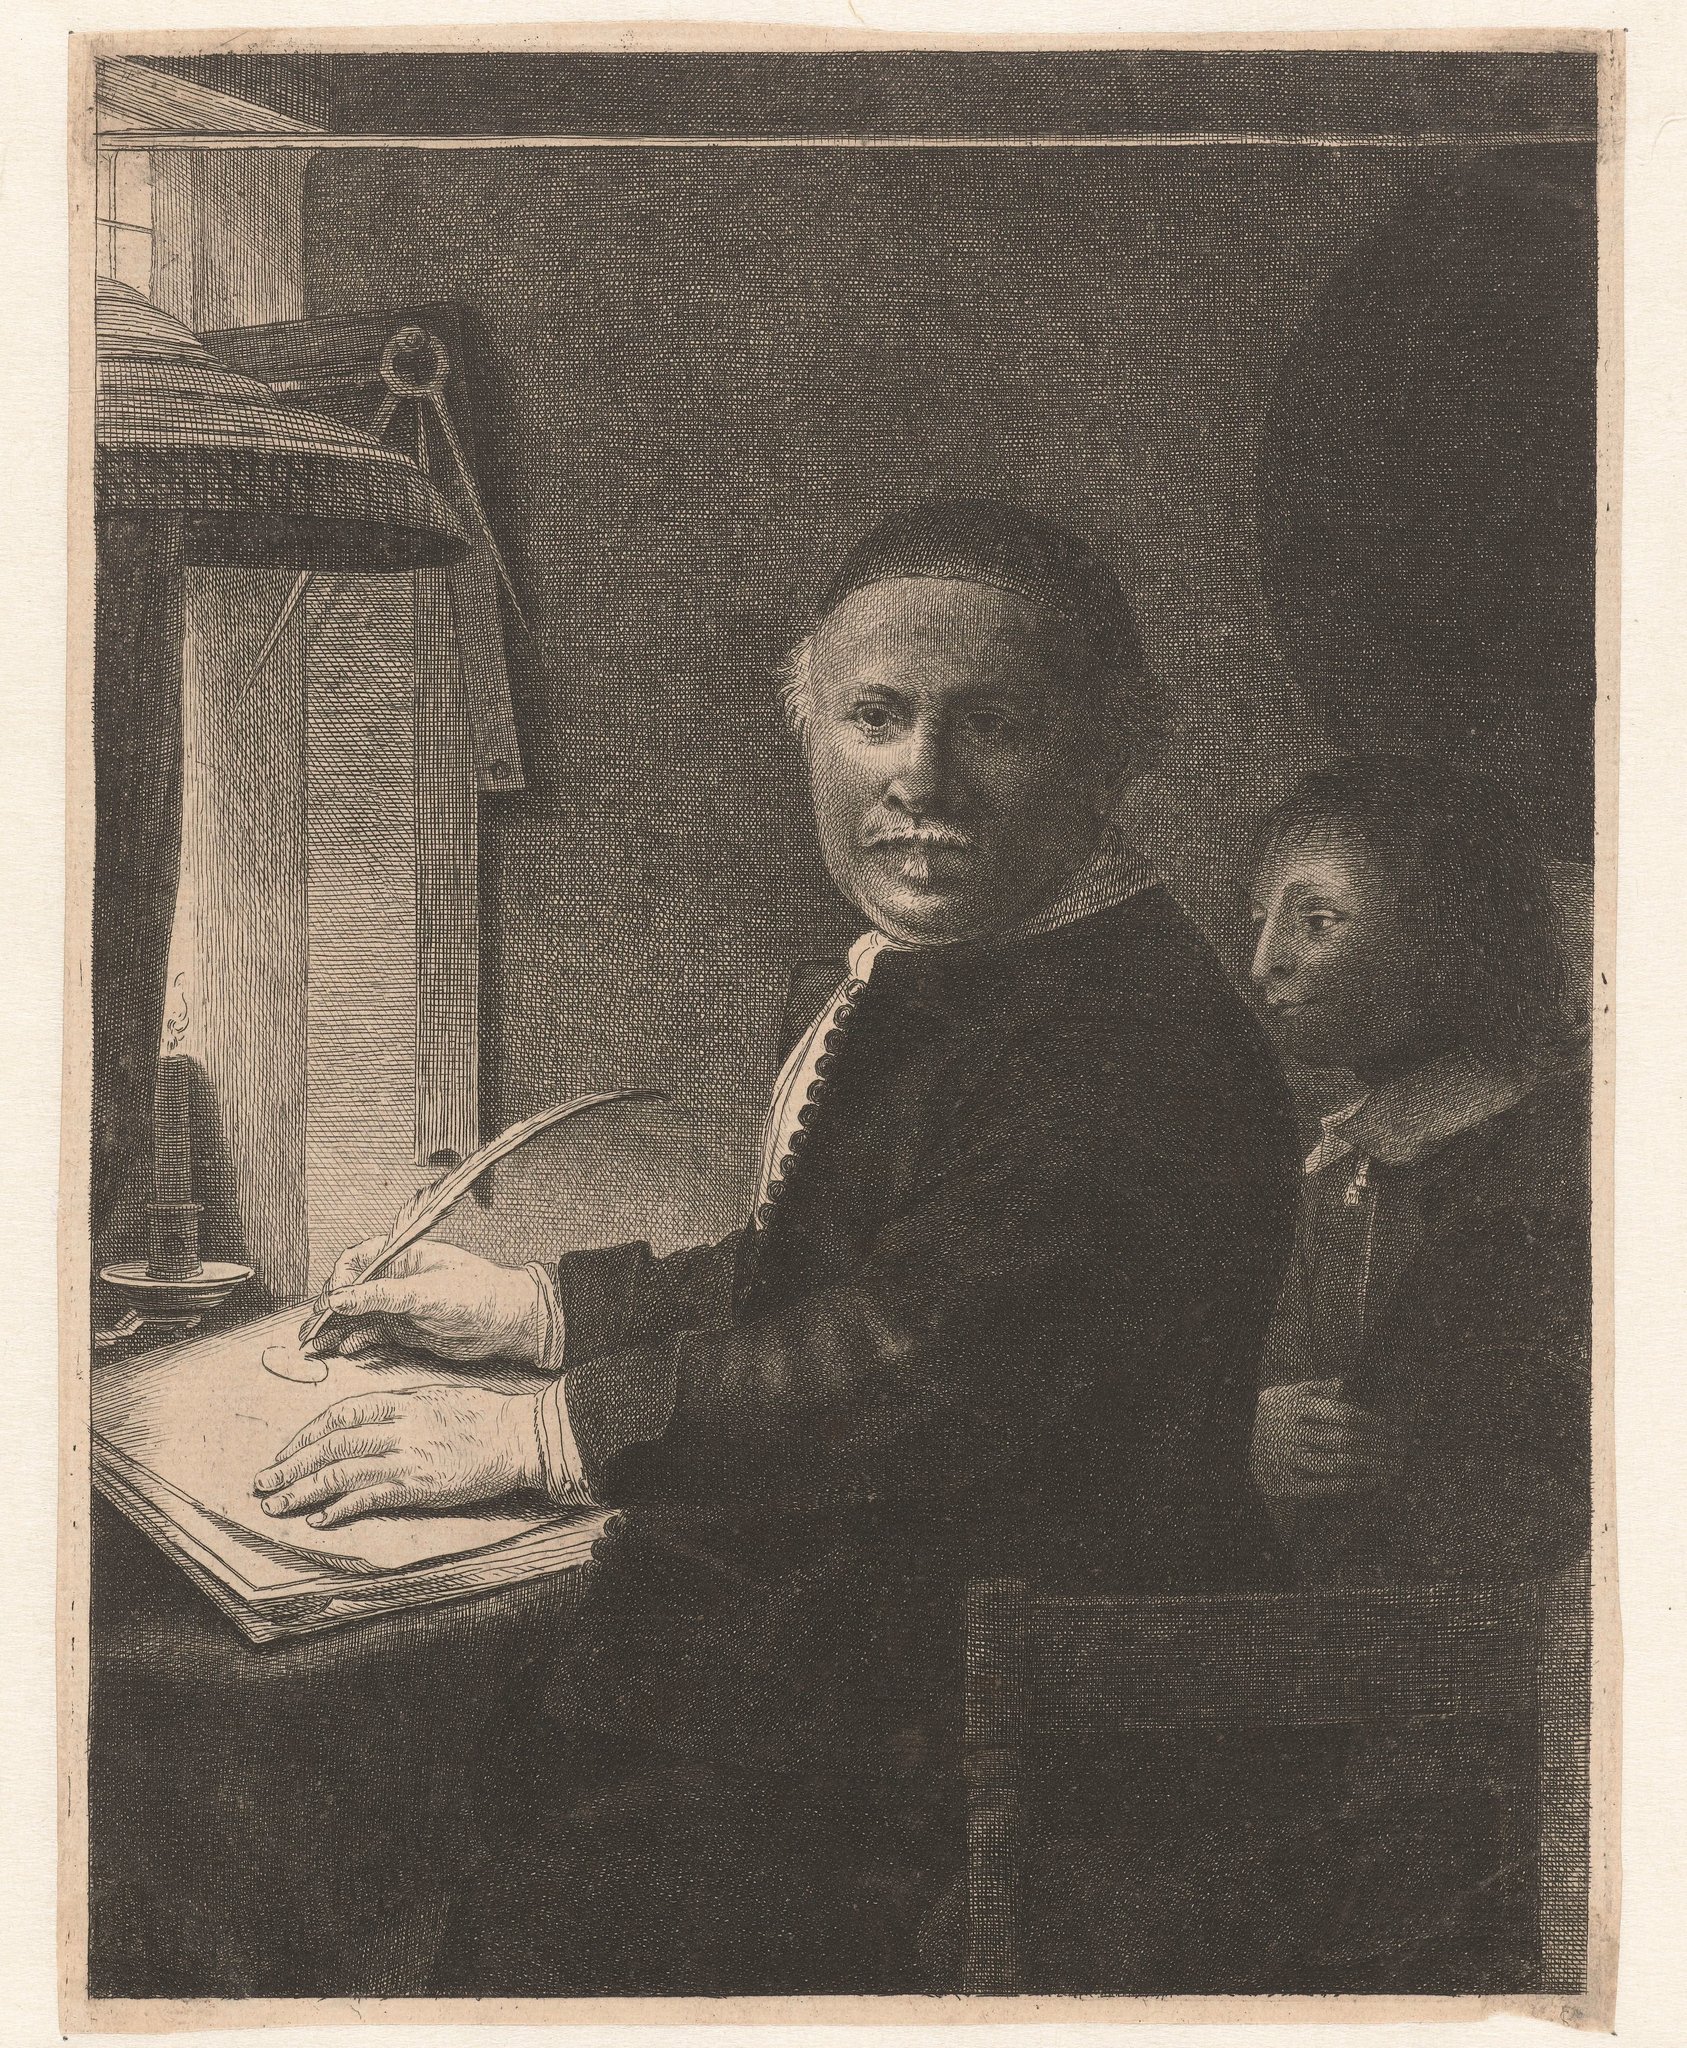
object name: print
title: Lieven Willemsz. van Coppenol, writing master: the smaller plate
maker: pierre françois basan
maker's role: print maker, publisher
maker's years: 1723-1797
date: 1733-1797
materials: paper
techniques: etching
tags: amsterdam, draughtsman, lieven willemsz. coppenol, historical persons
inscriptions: collector's mark: Lugt 2228, collector's mark: Lugt 2760